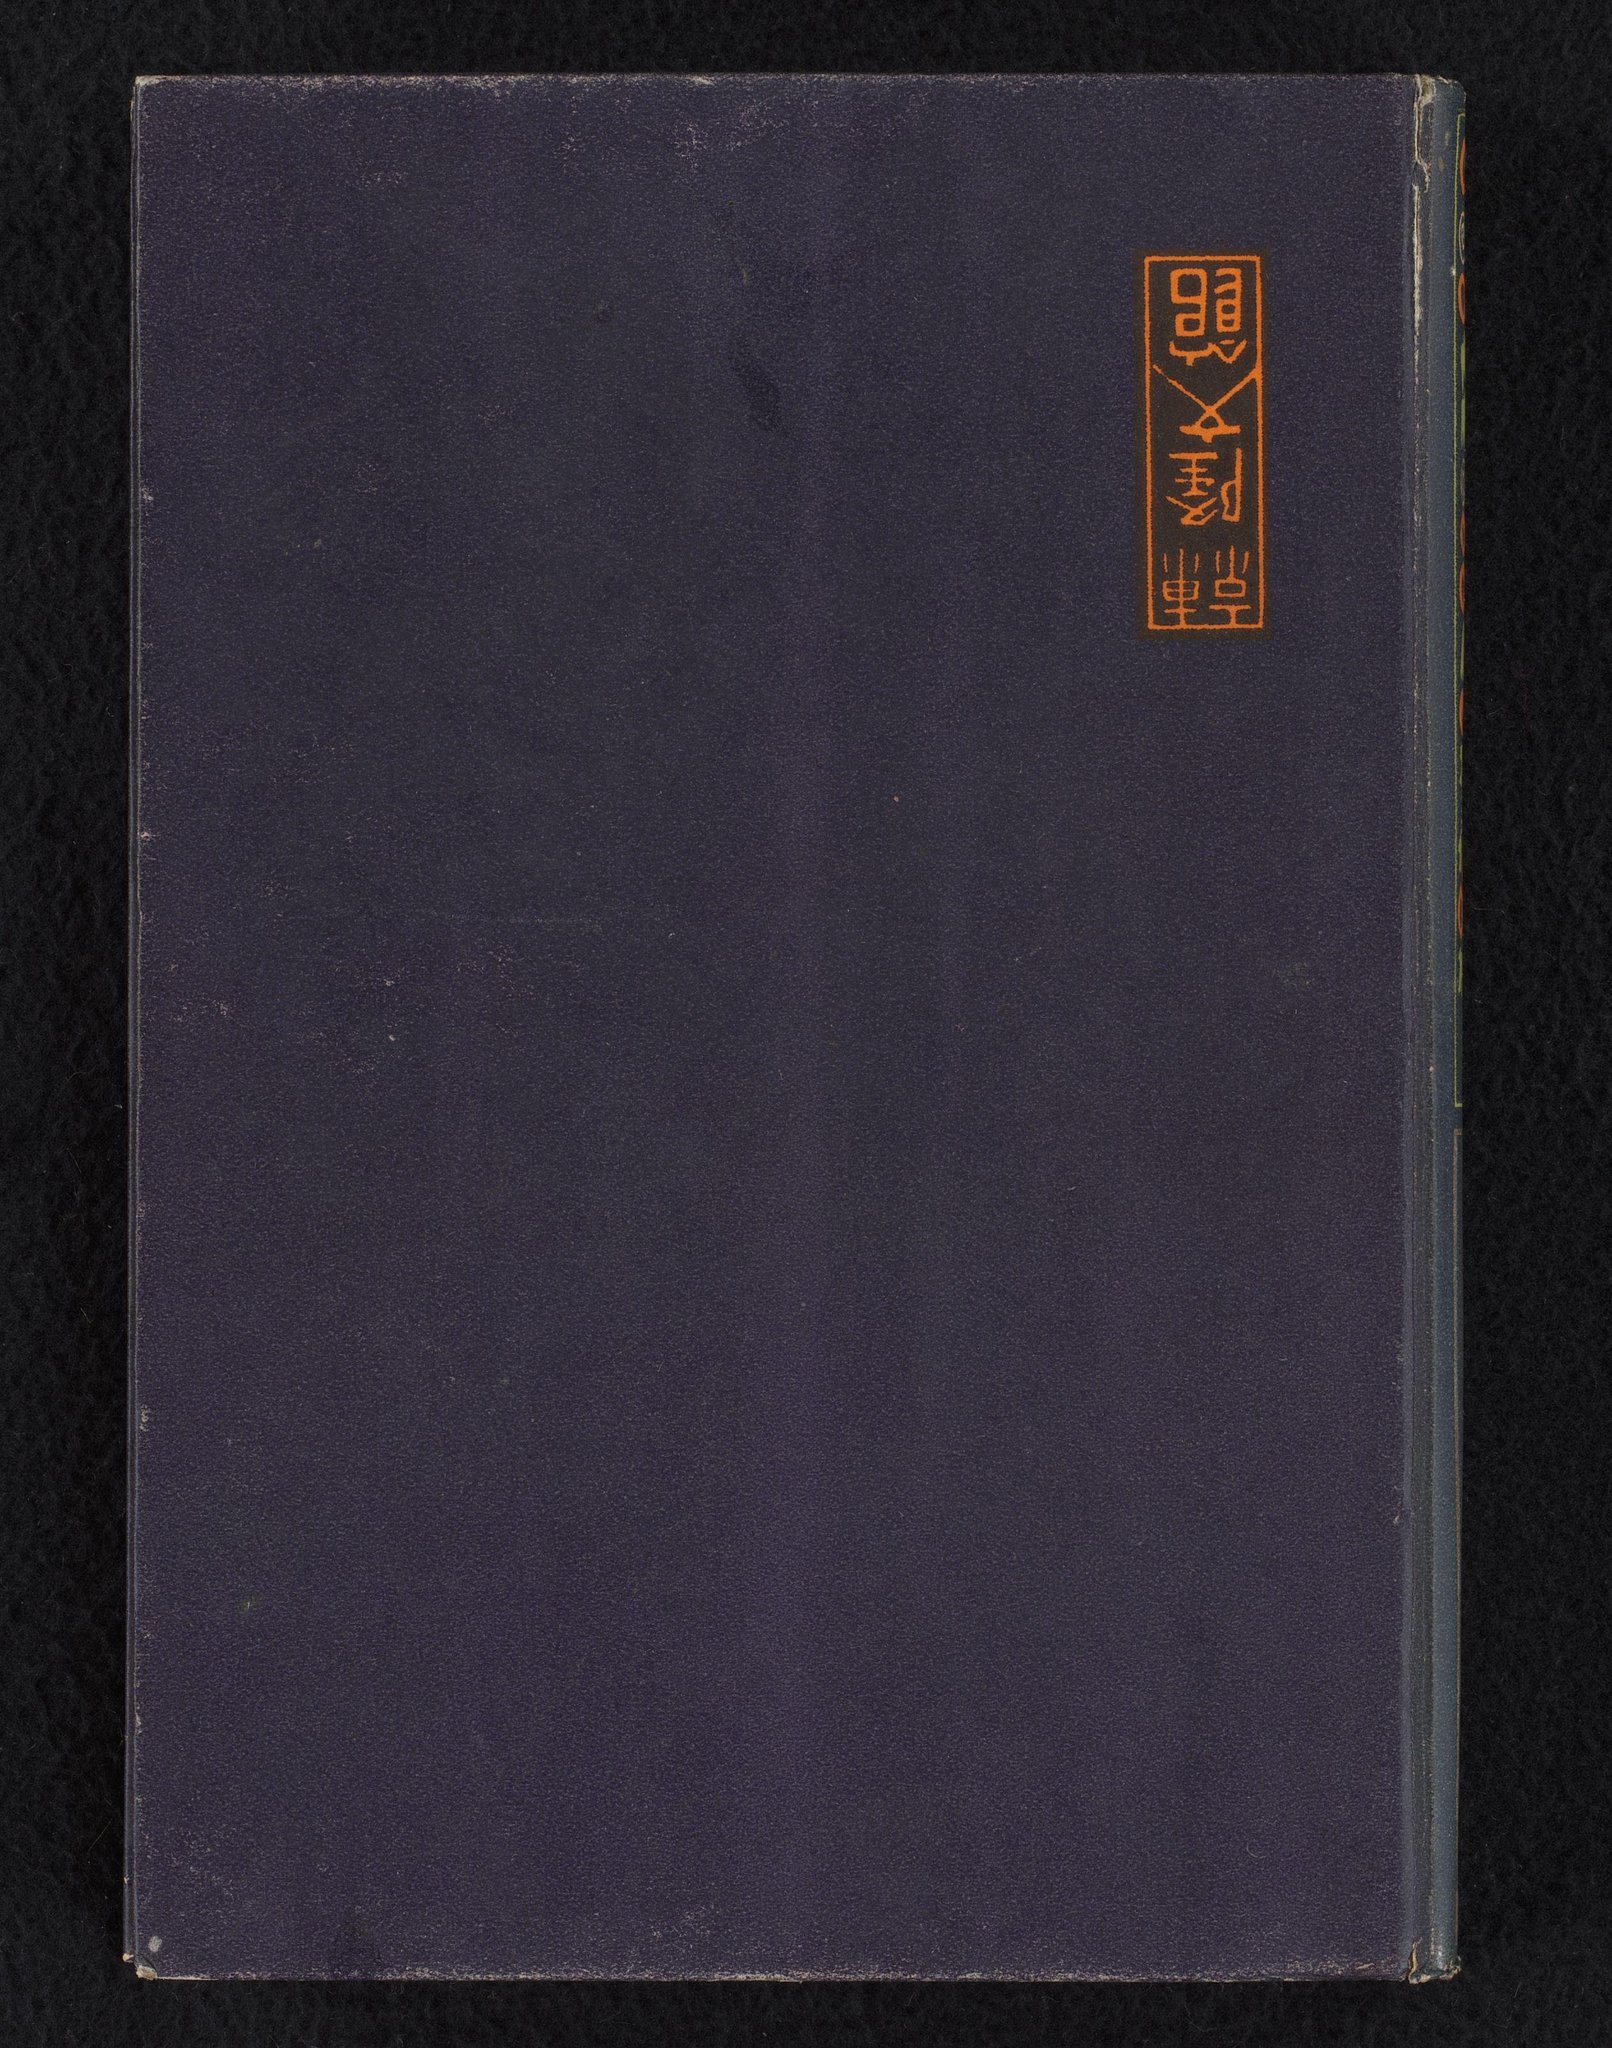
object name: book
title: Nieuwe draaikolken - een roman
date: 1914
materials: paper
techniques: woodcut, letterpress printing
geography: japan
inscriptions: date